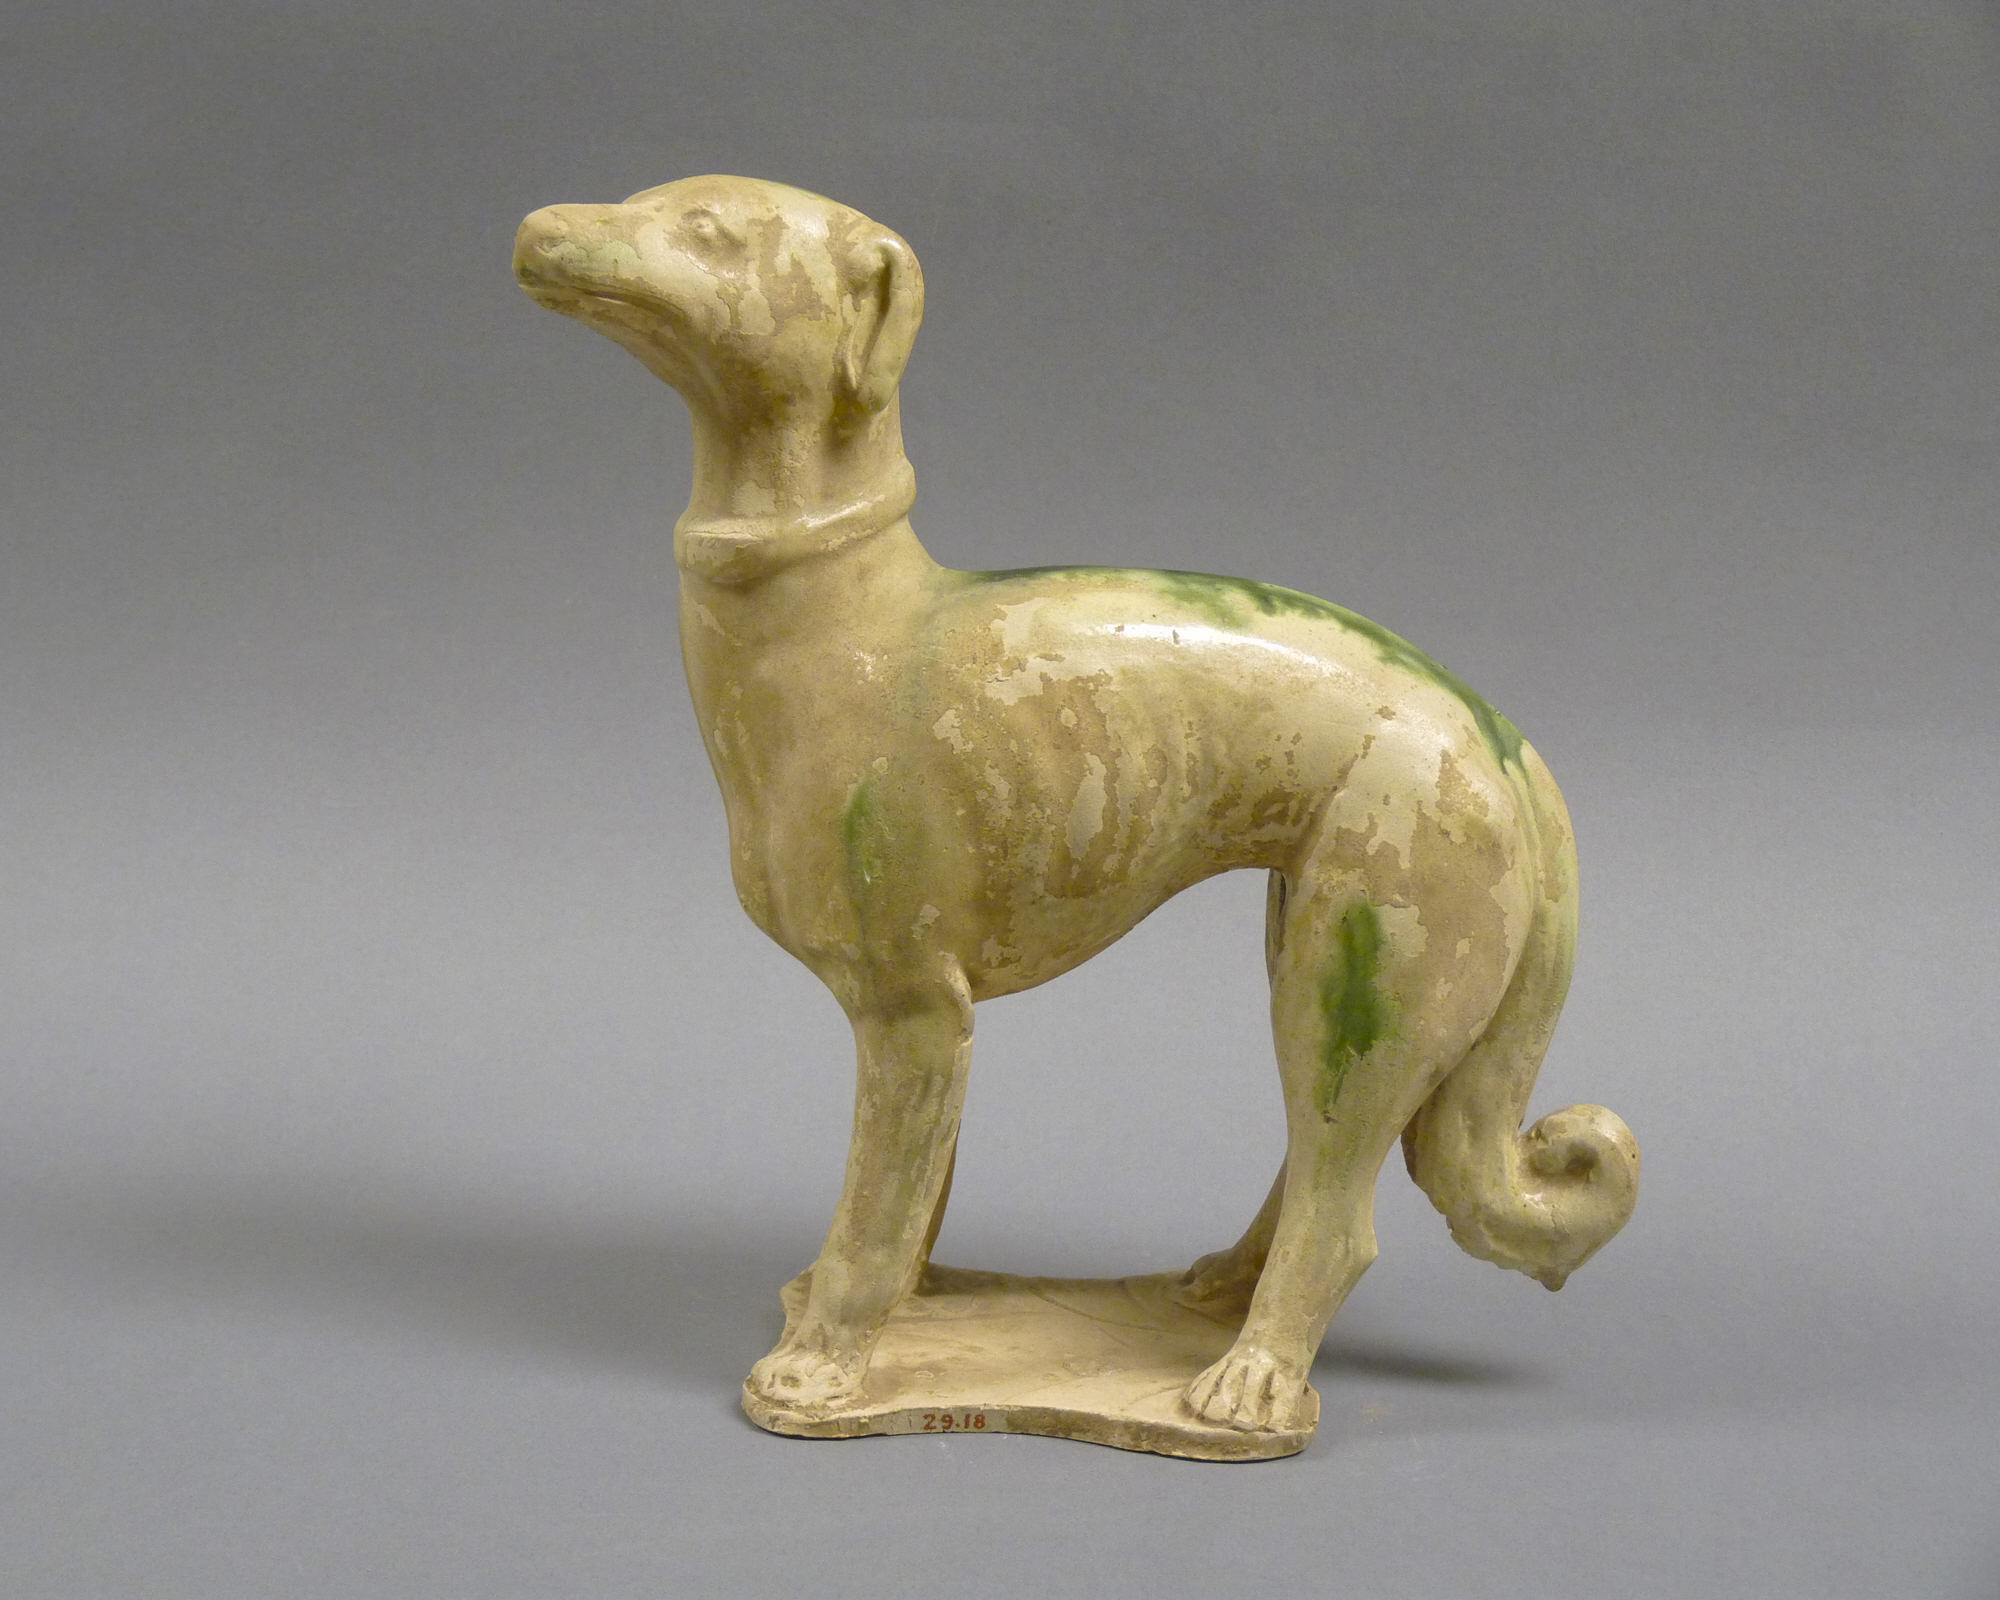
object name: figure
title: Dog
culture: chinese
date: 601-800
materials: earthenware, glaze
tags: dogs